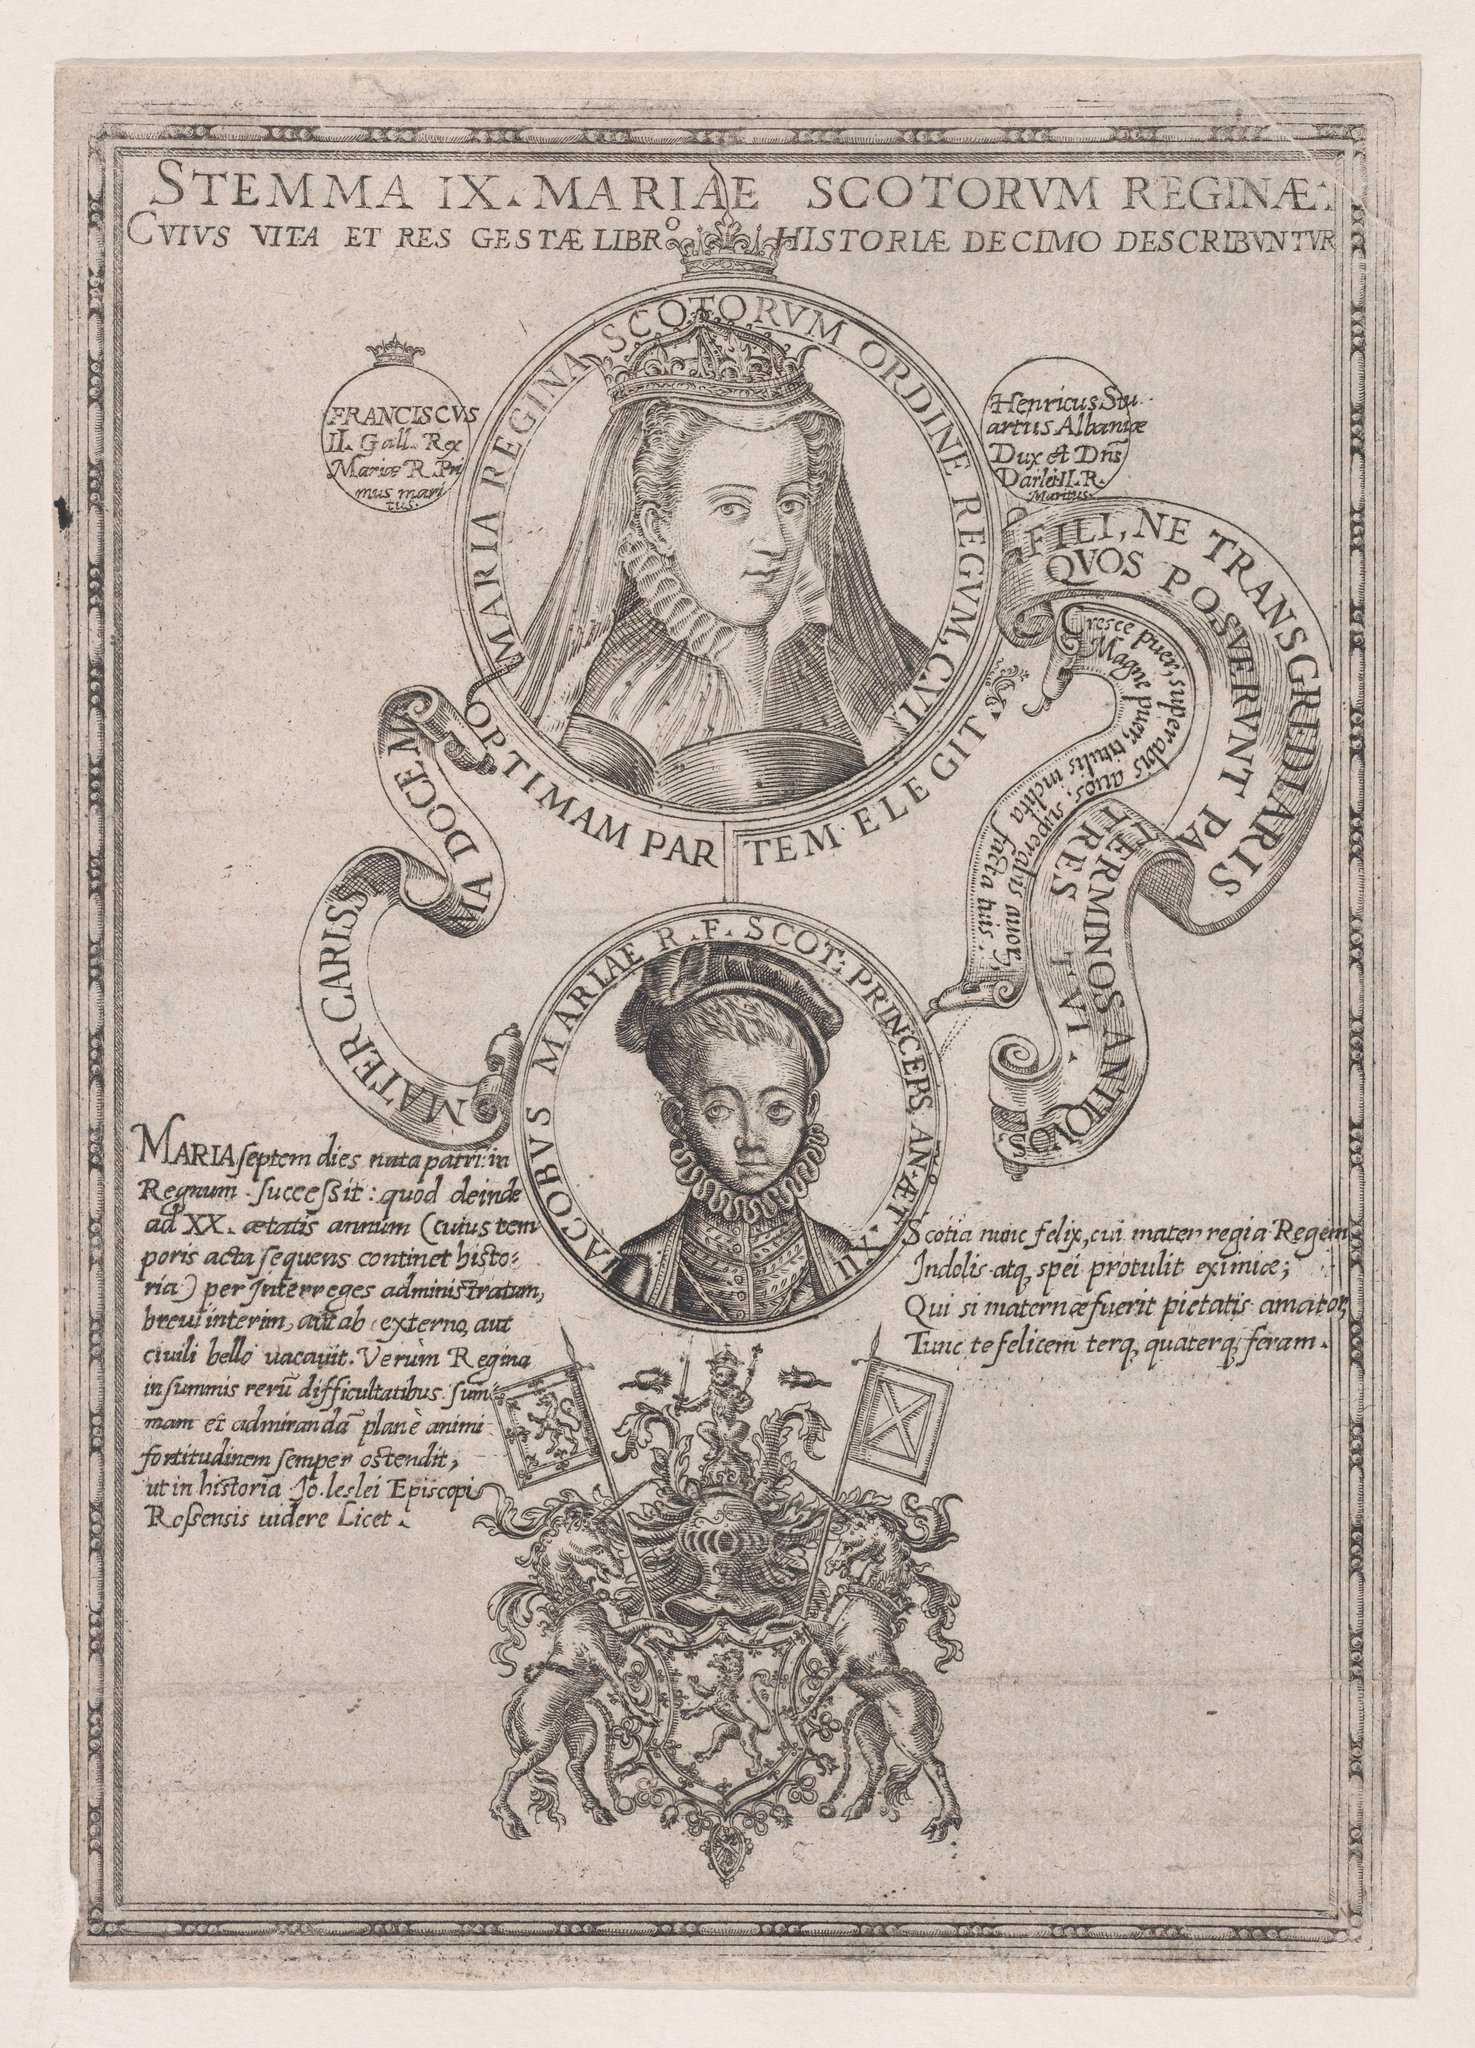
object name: print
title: Mary, Queen of Scots with her son, James I, King of England, Scotland and Ireland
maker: john leslie, bishop of ross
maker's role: artist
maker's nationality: british, scottish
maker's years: 1527-1596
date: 1578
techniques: engraving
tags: men,portraits,women,mary queen of scots